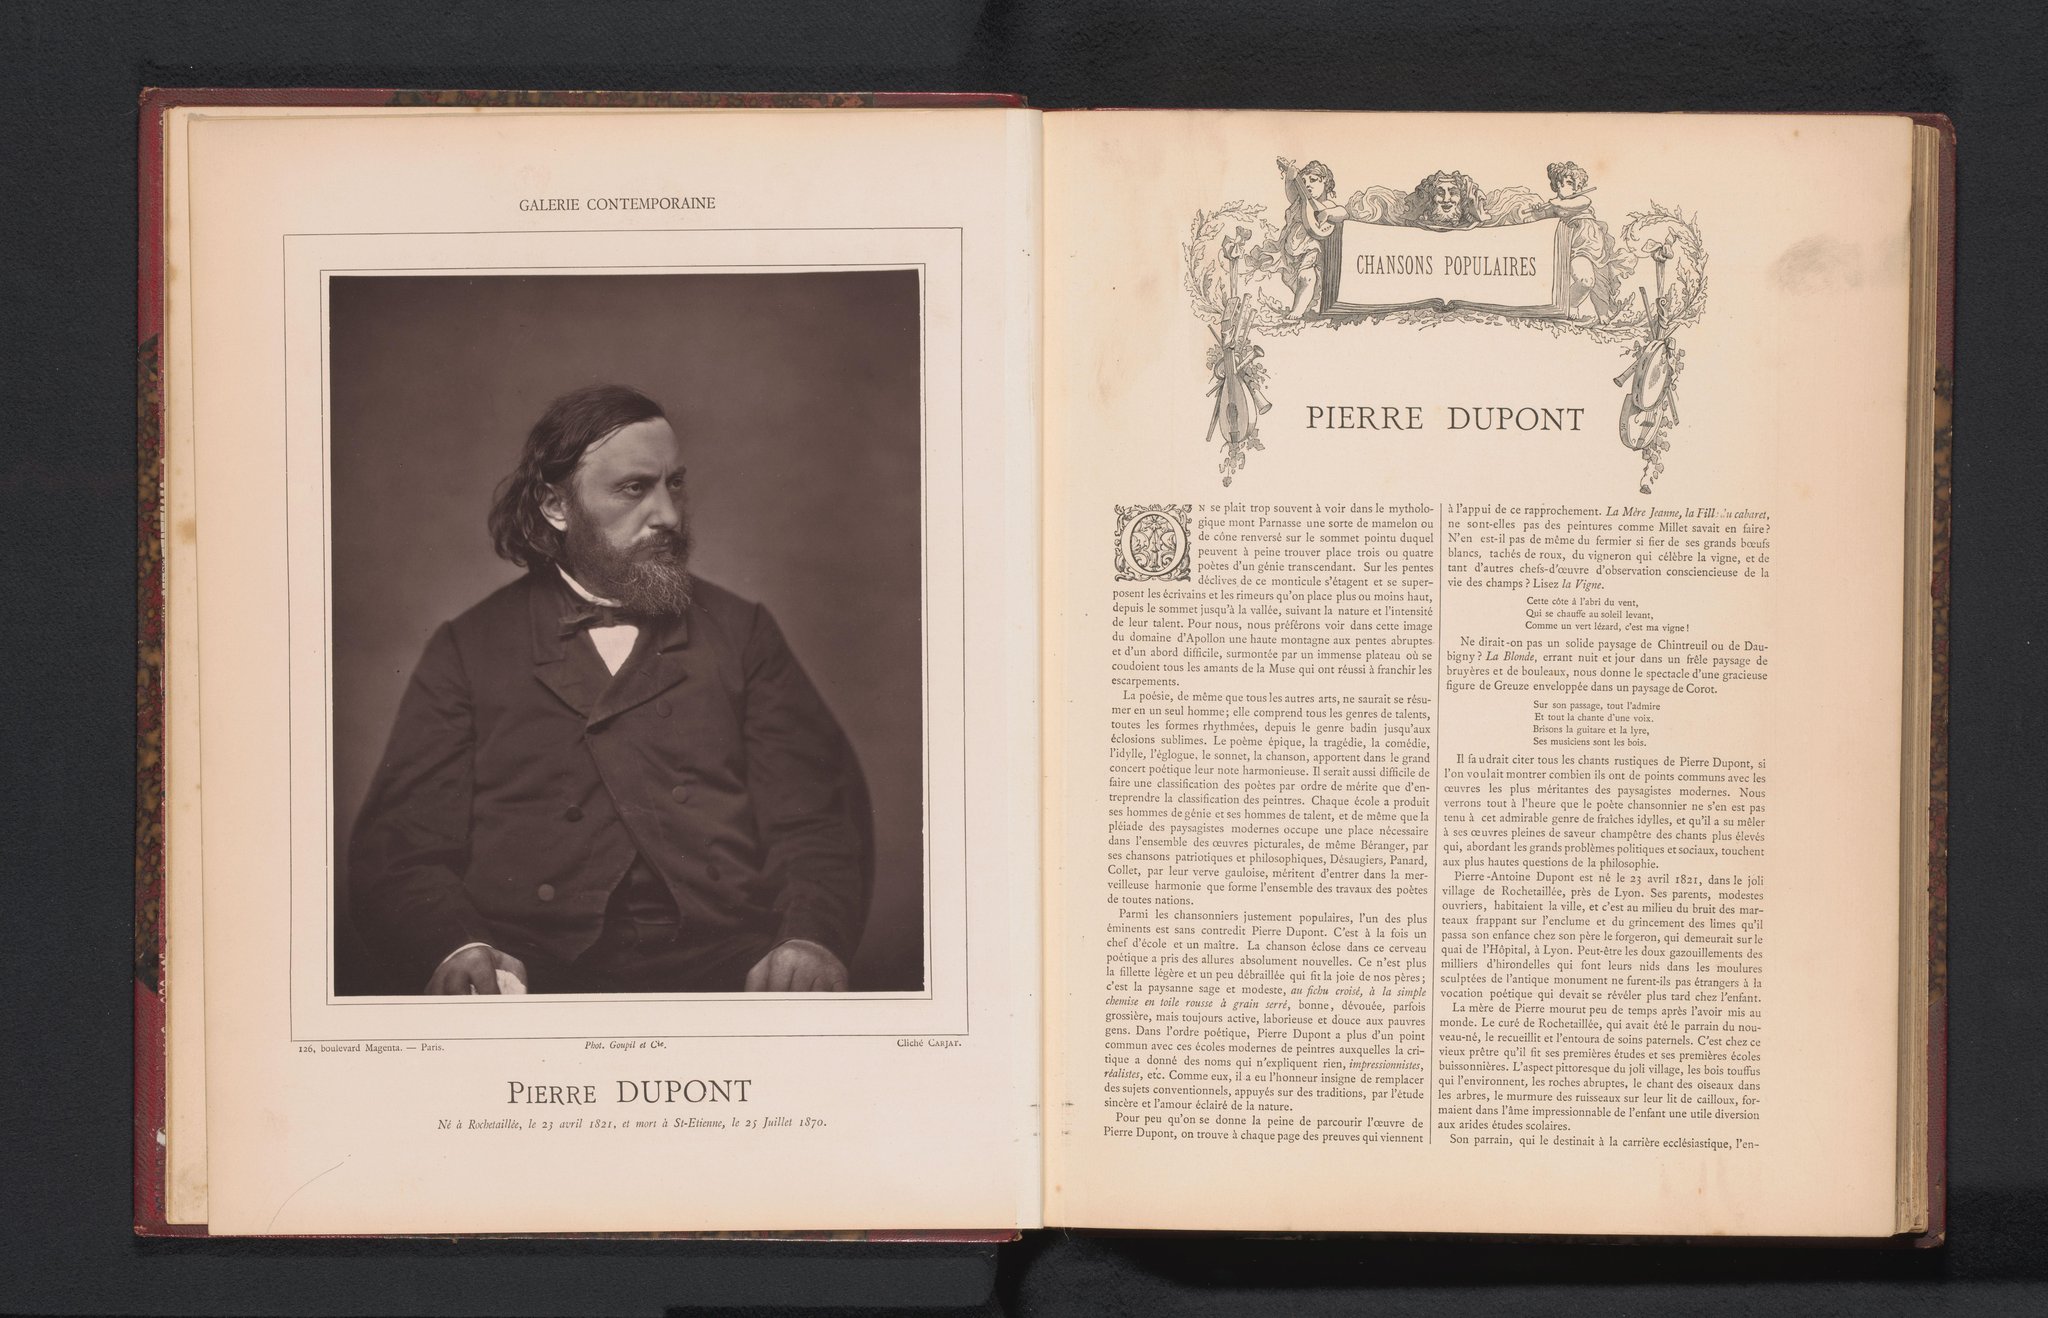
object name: page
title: Portret van Pierre Dupont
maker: étienne carjat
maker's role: draughtsman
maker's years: 1828-1906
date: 1873-1878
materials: paper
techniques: woodburytype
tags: lyon, adult man, historical persons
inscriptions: inscription: ‘Galerie Contemporaine/ 126, boulevard Magenta. - Paris./Né à Rochetaillee, le 23 avril 1821, et mort à St-Etienne, le 25 Juillet 1870.’